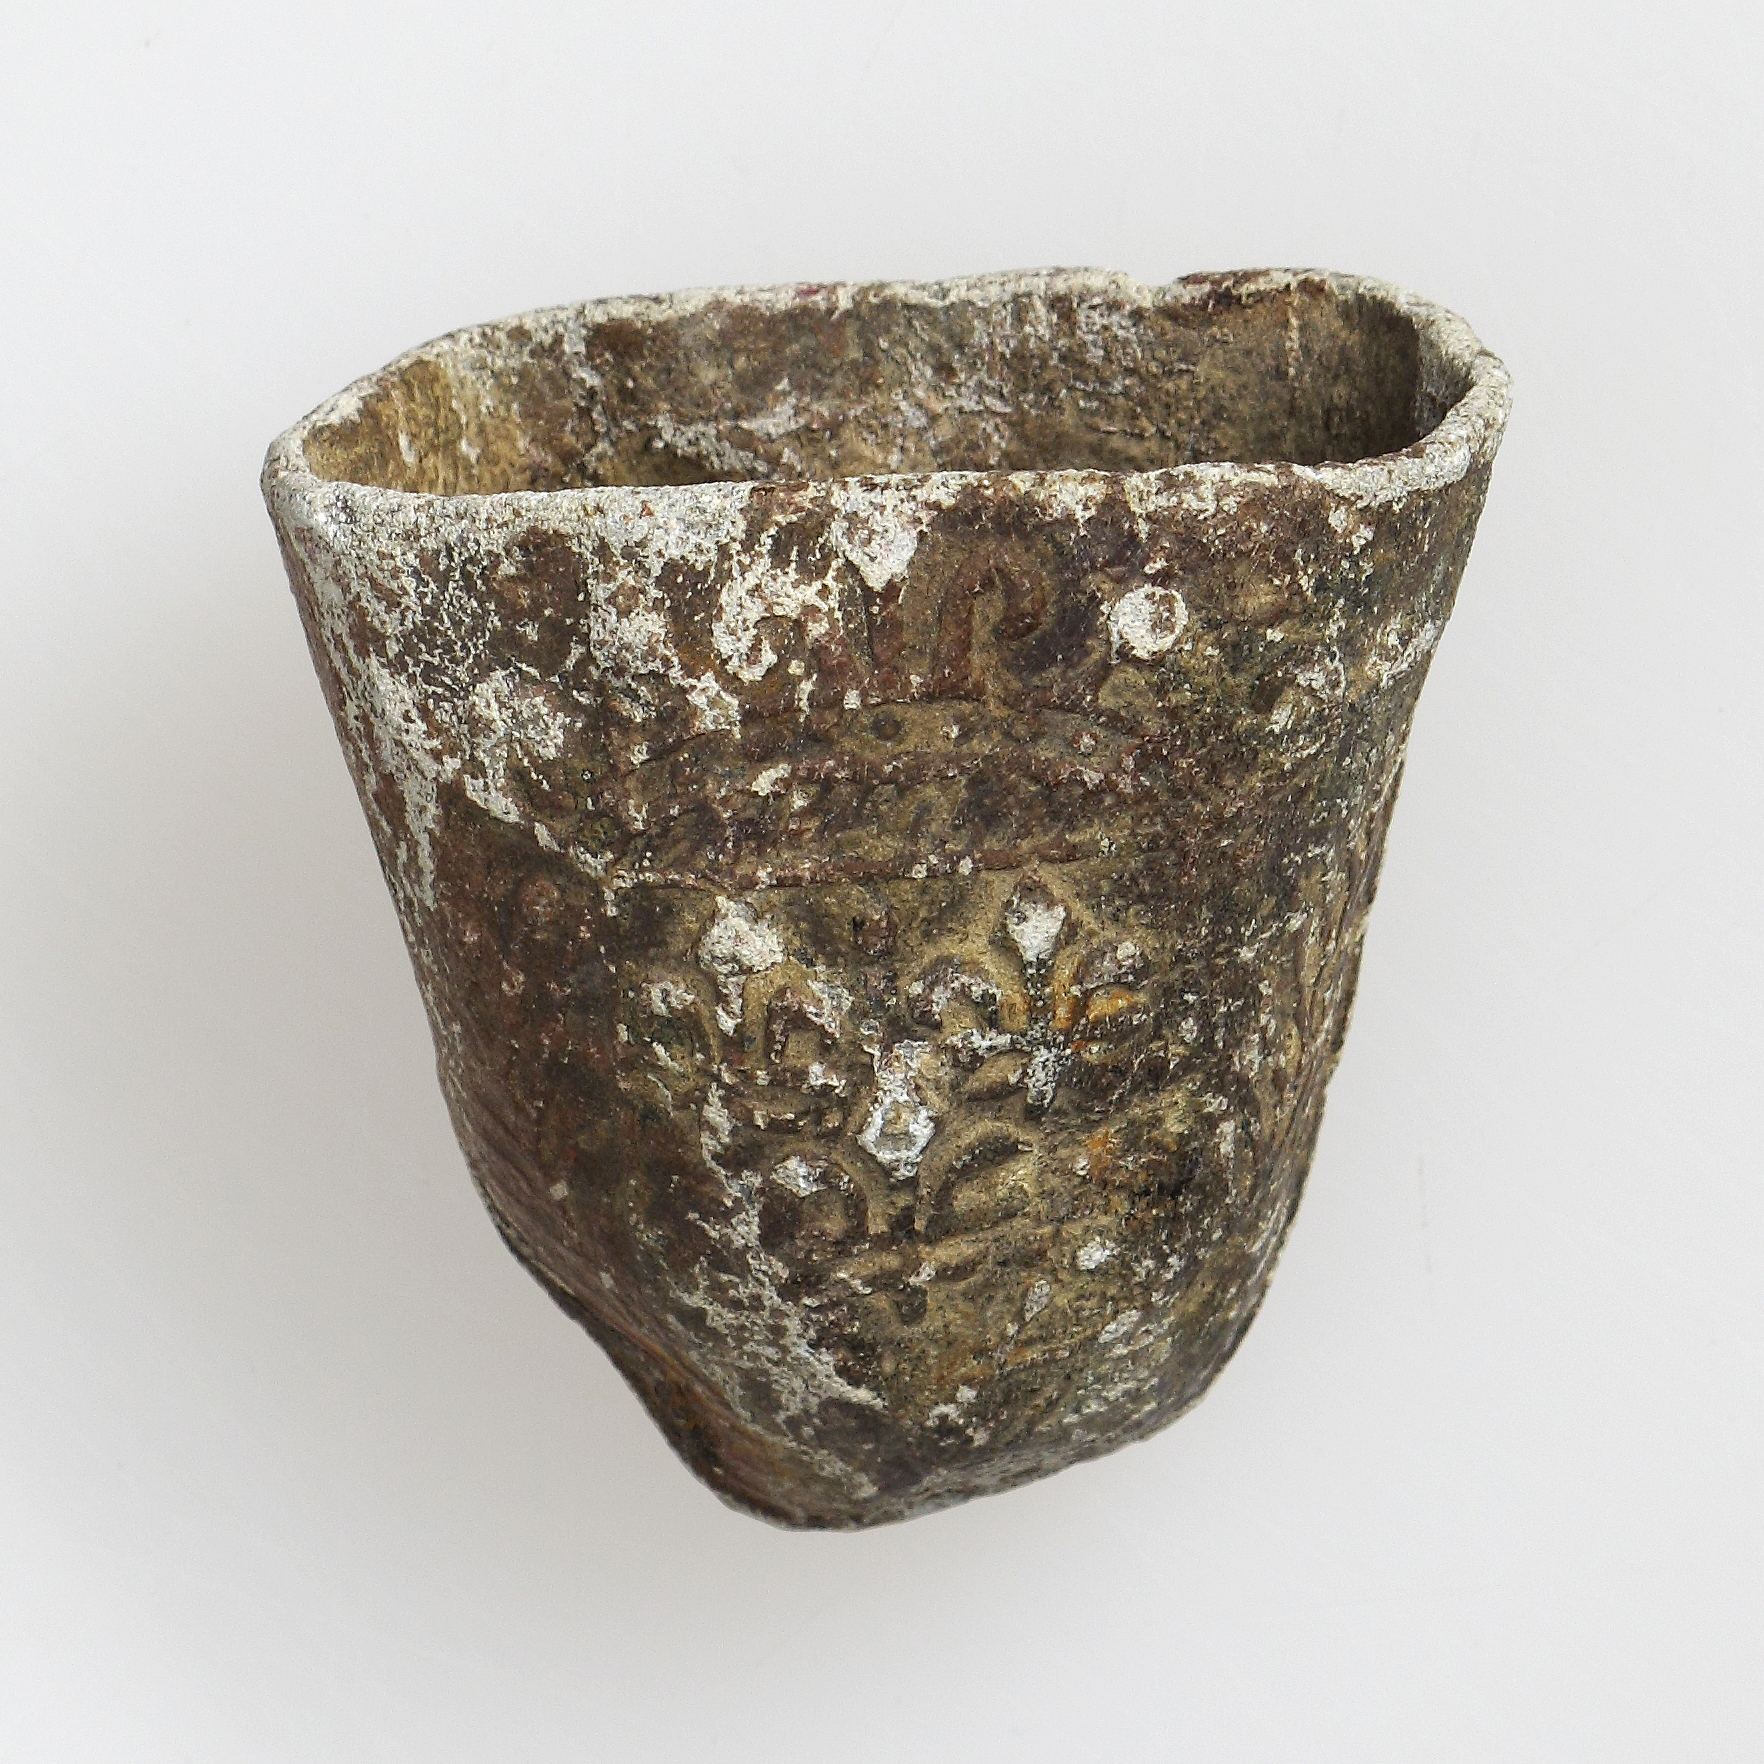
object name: bird feeder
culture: french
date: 1301-1500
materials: lead